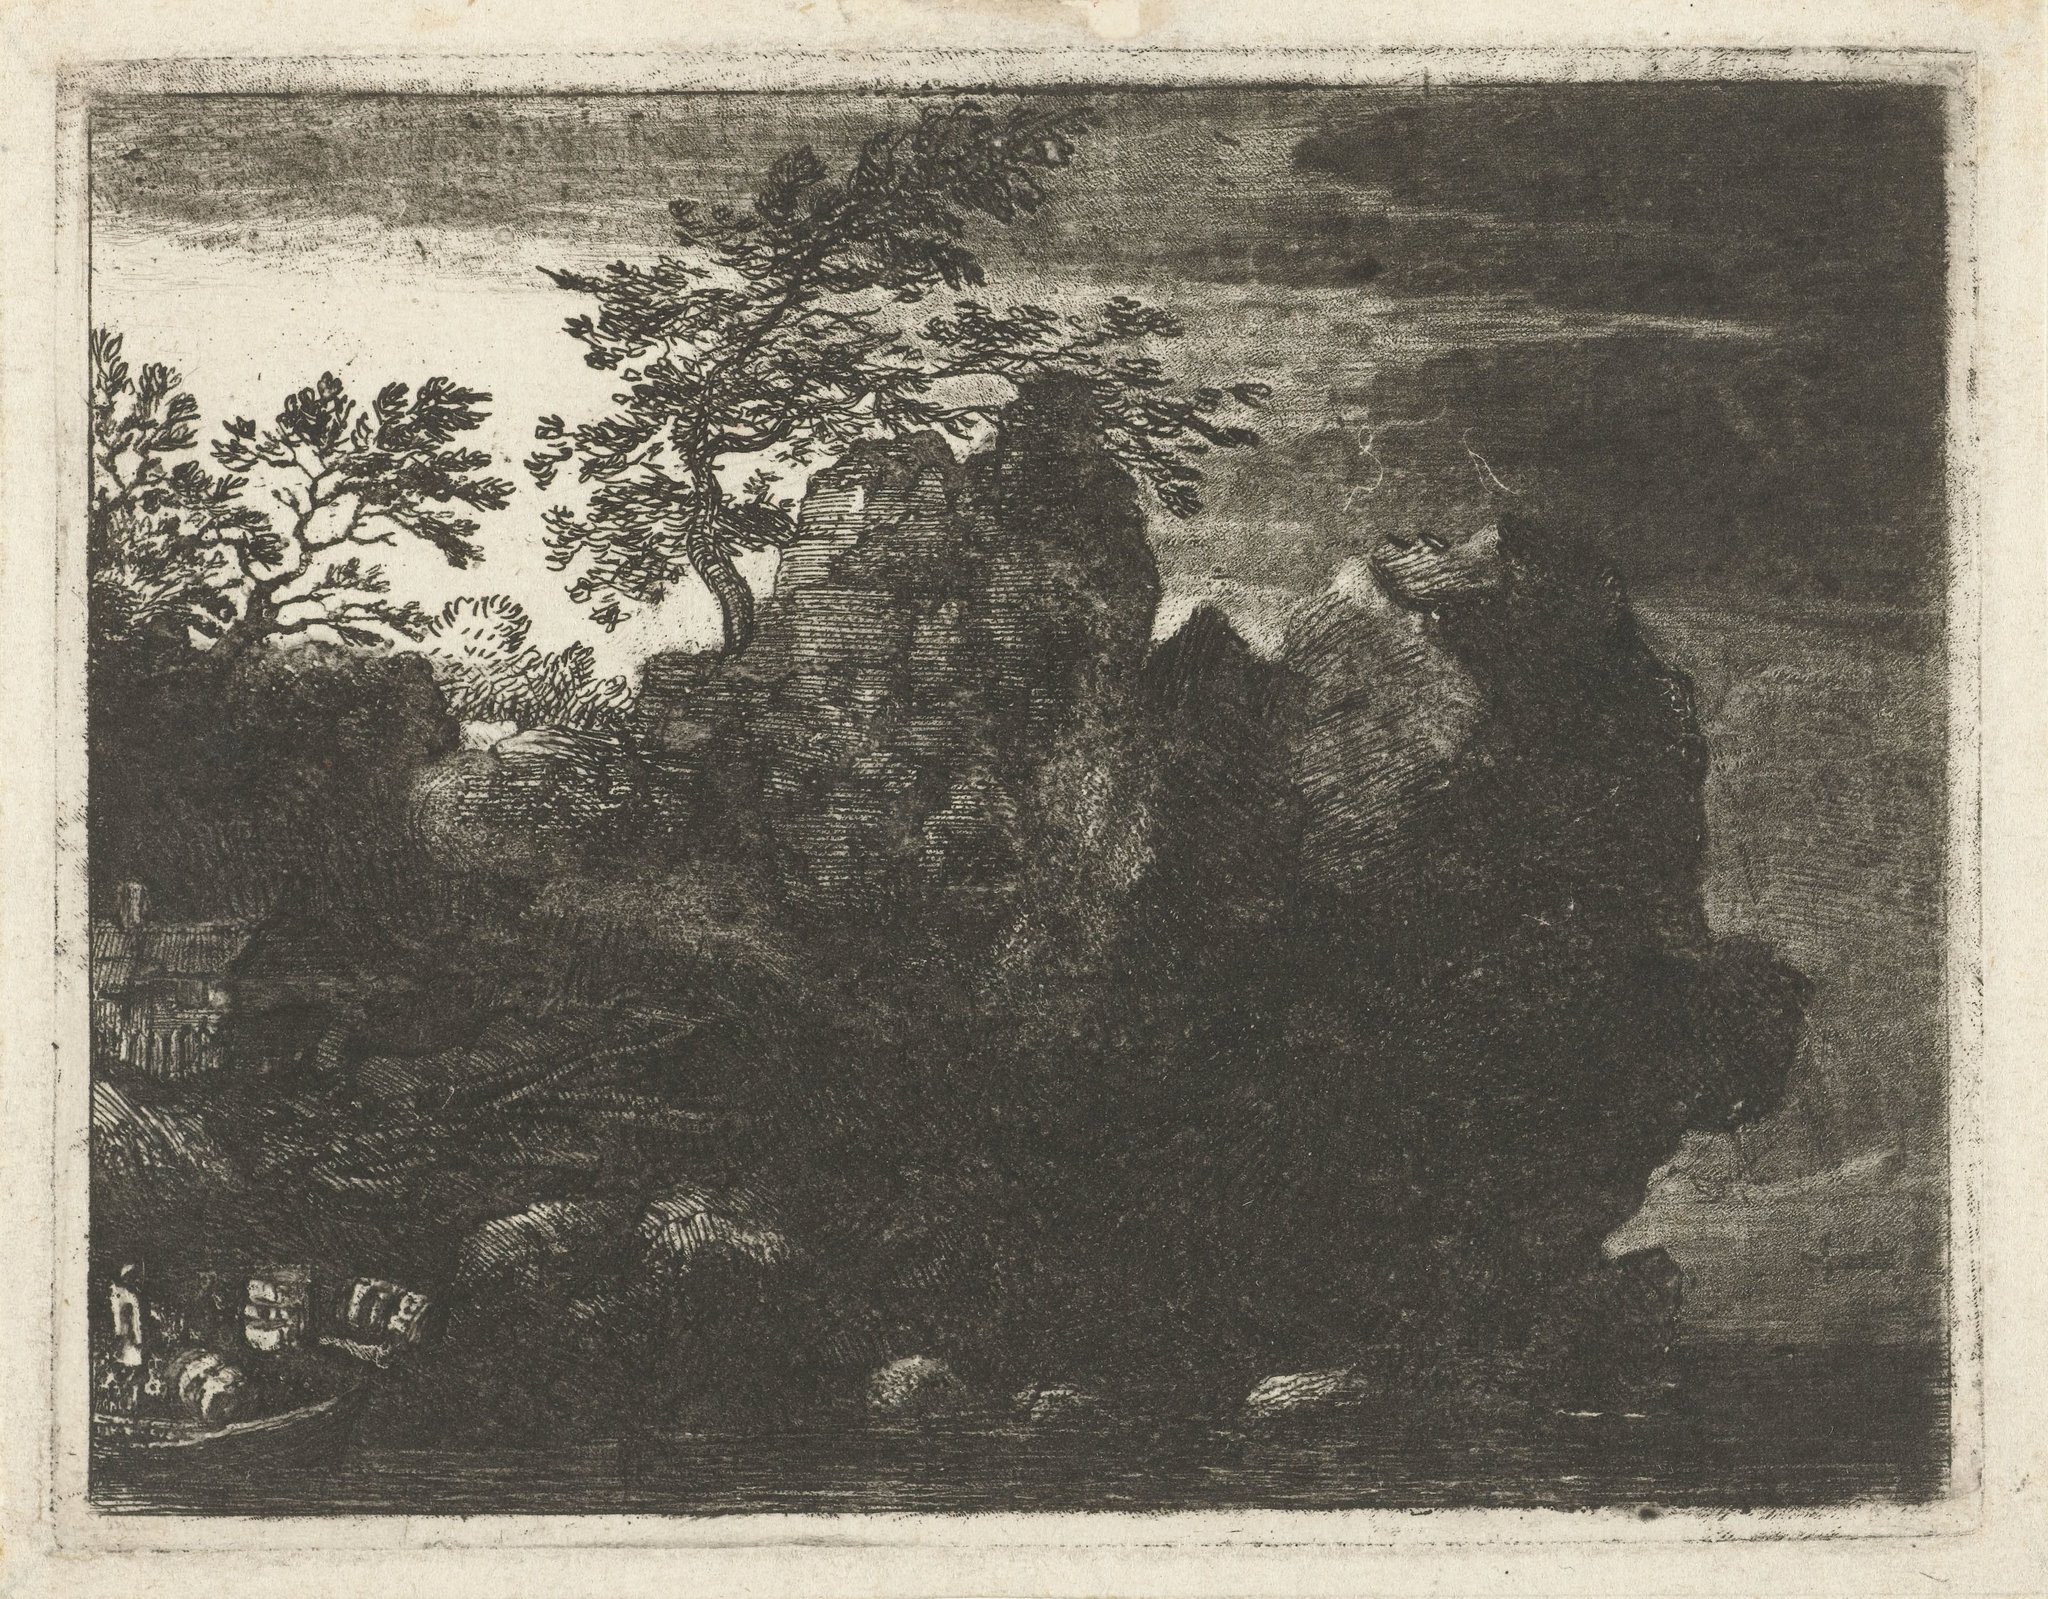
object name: print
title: Grote rotspartij bij rivier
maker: allaert van everdingen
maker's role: draughtsman, painter, print maker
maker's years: 1621-1675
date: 1631-1675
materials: paper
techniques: etching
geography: netherlands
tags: rock-formations (+ landscape with figures, staffage)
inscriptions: collector's mark: Lugt 2228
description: Gezicht op een grote rotspartij aan het water, bij nacht. Op de voorgrond een kleine sloep en enkele houten tonnen.